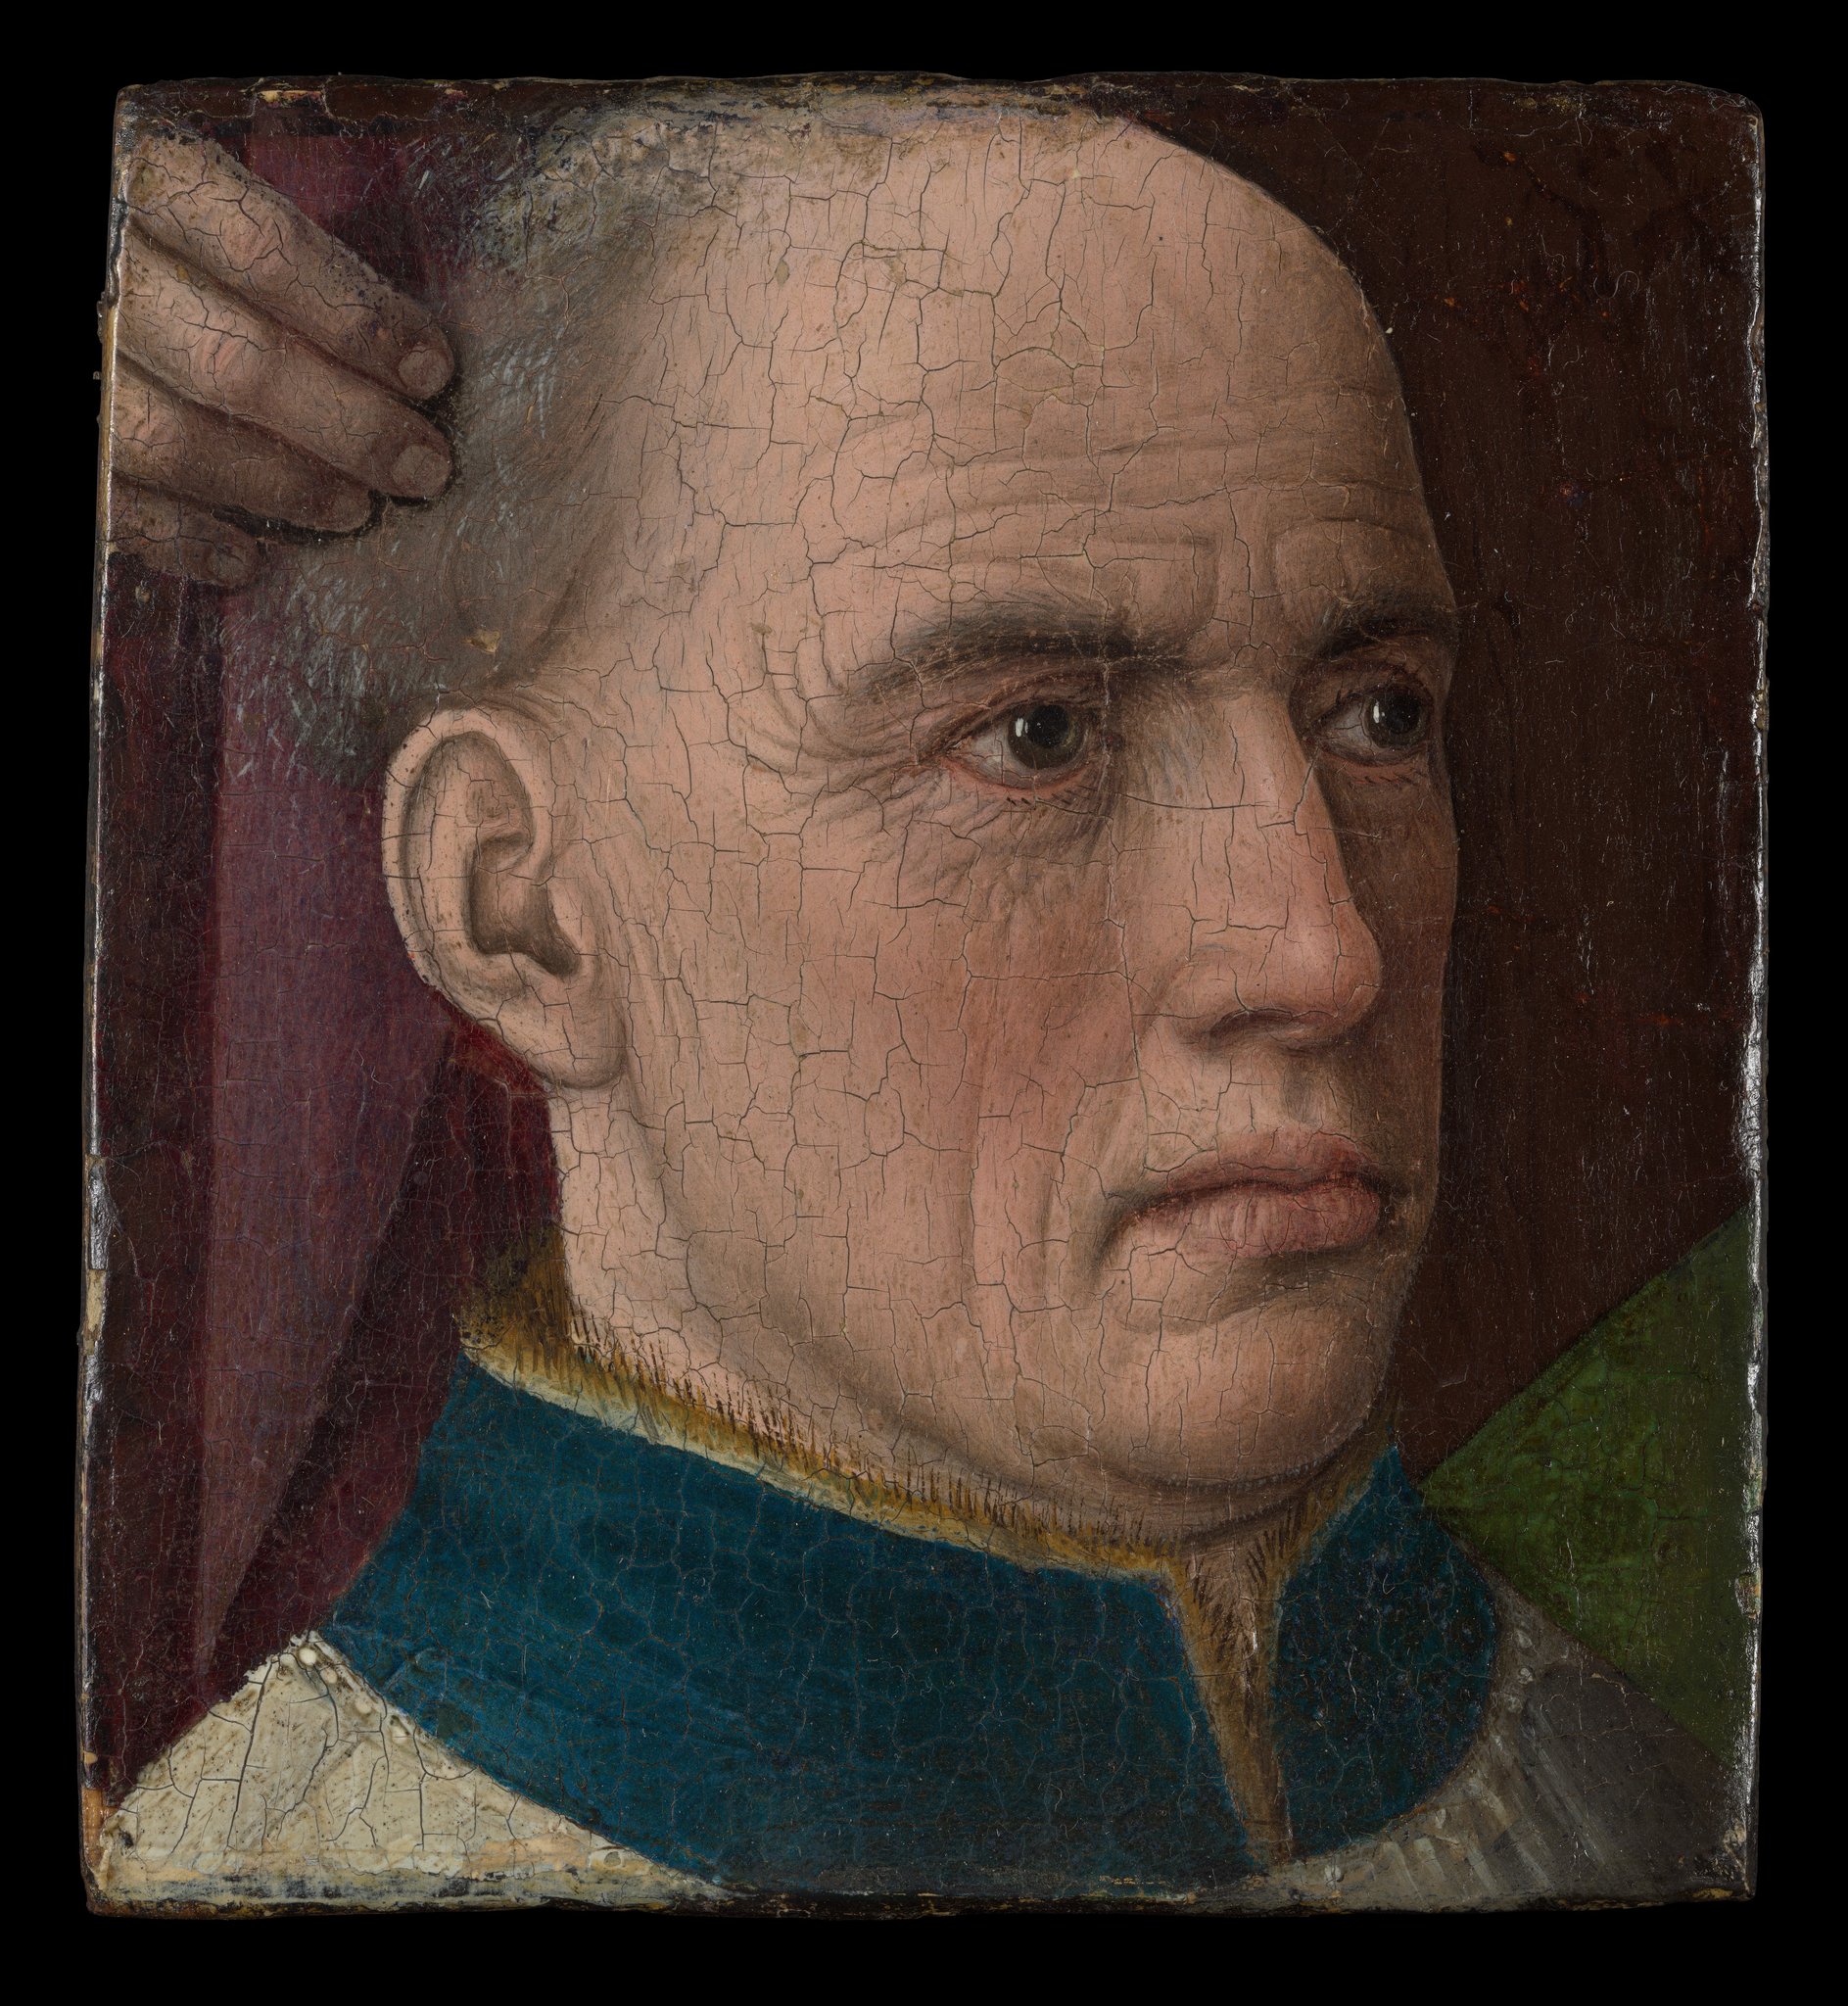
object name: painting fragment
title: Head of a Donor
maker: albert van ouwater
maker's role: artist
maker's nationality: netherlandish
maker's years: 1410-1475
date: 1465-1470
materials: oil, wood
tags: men,portraits